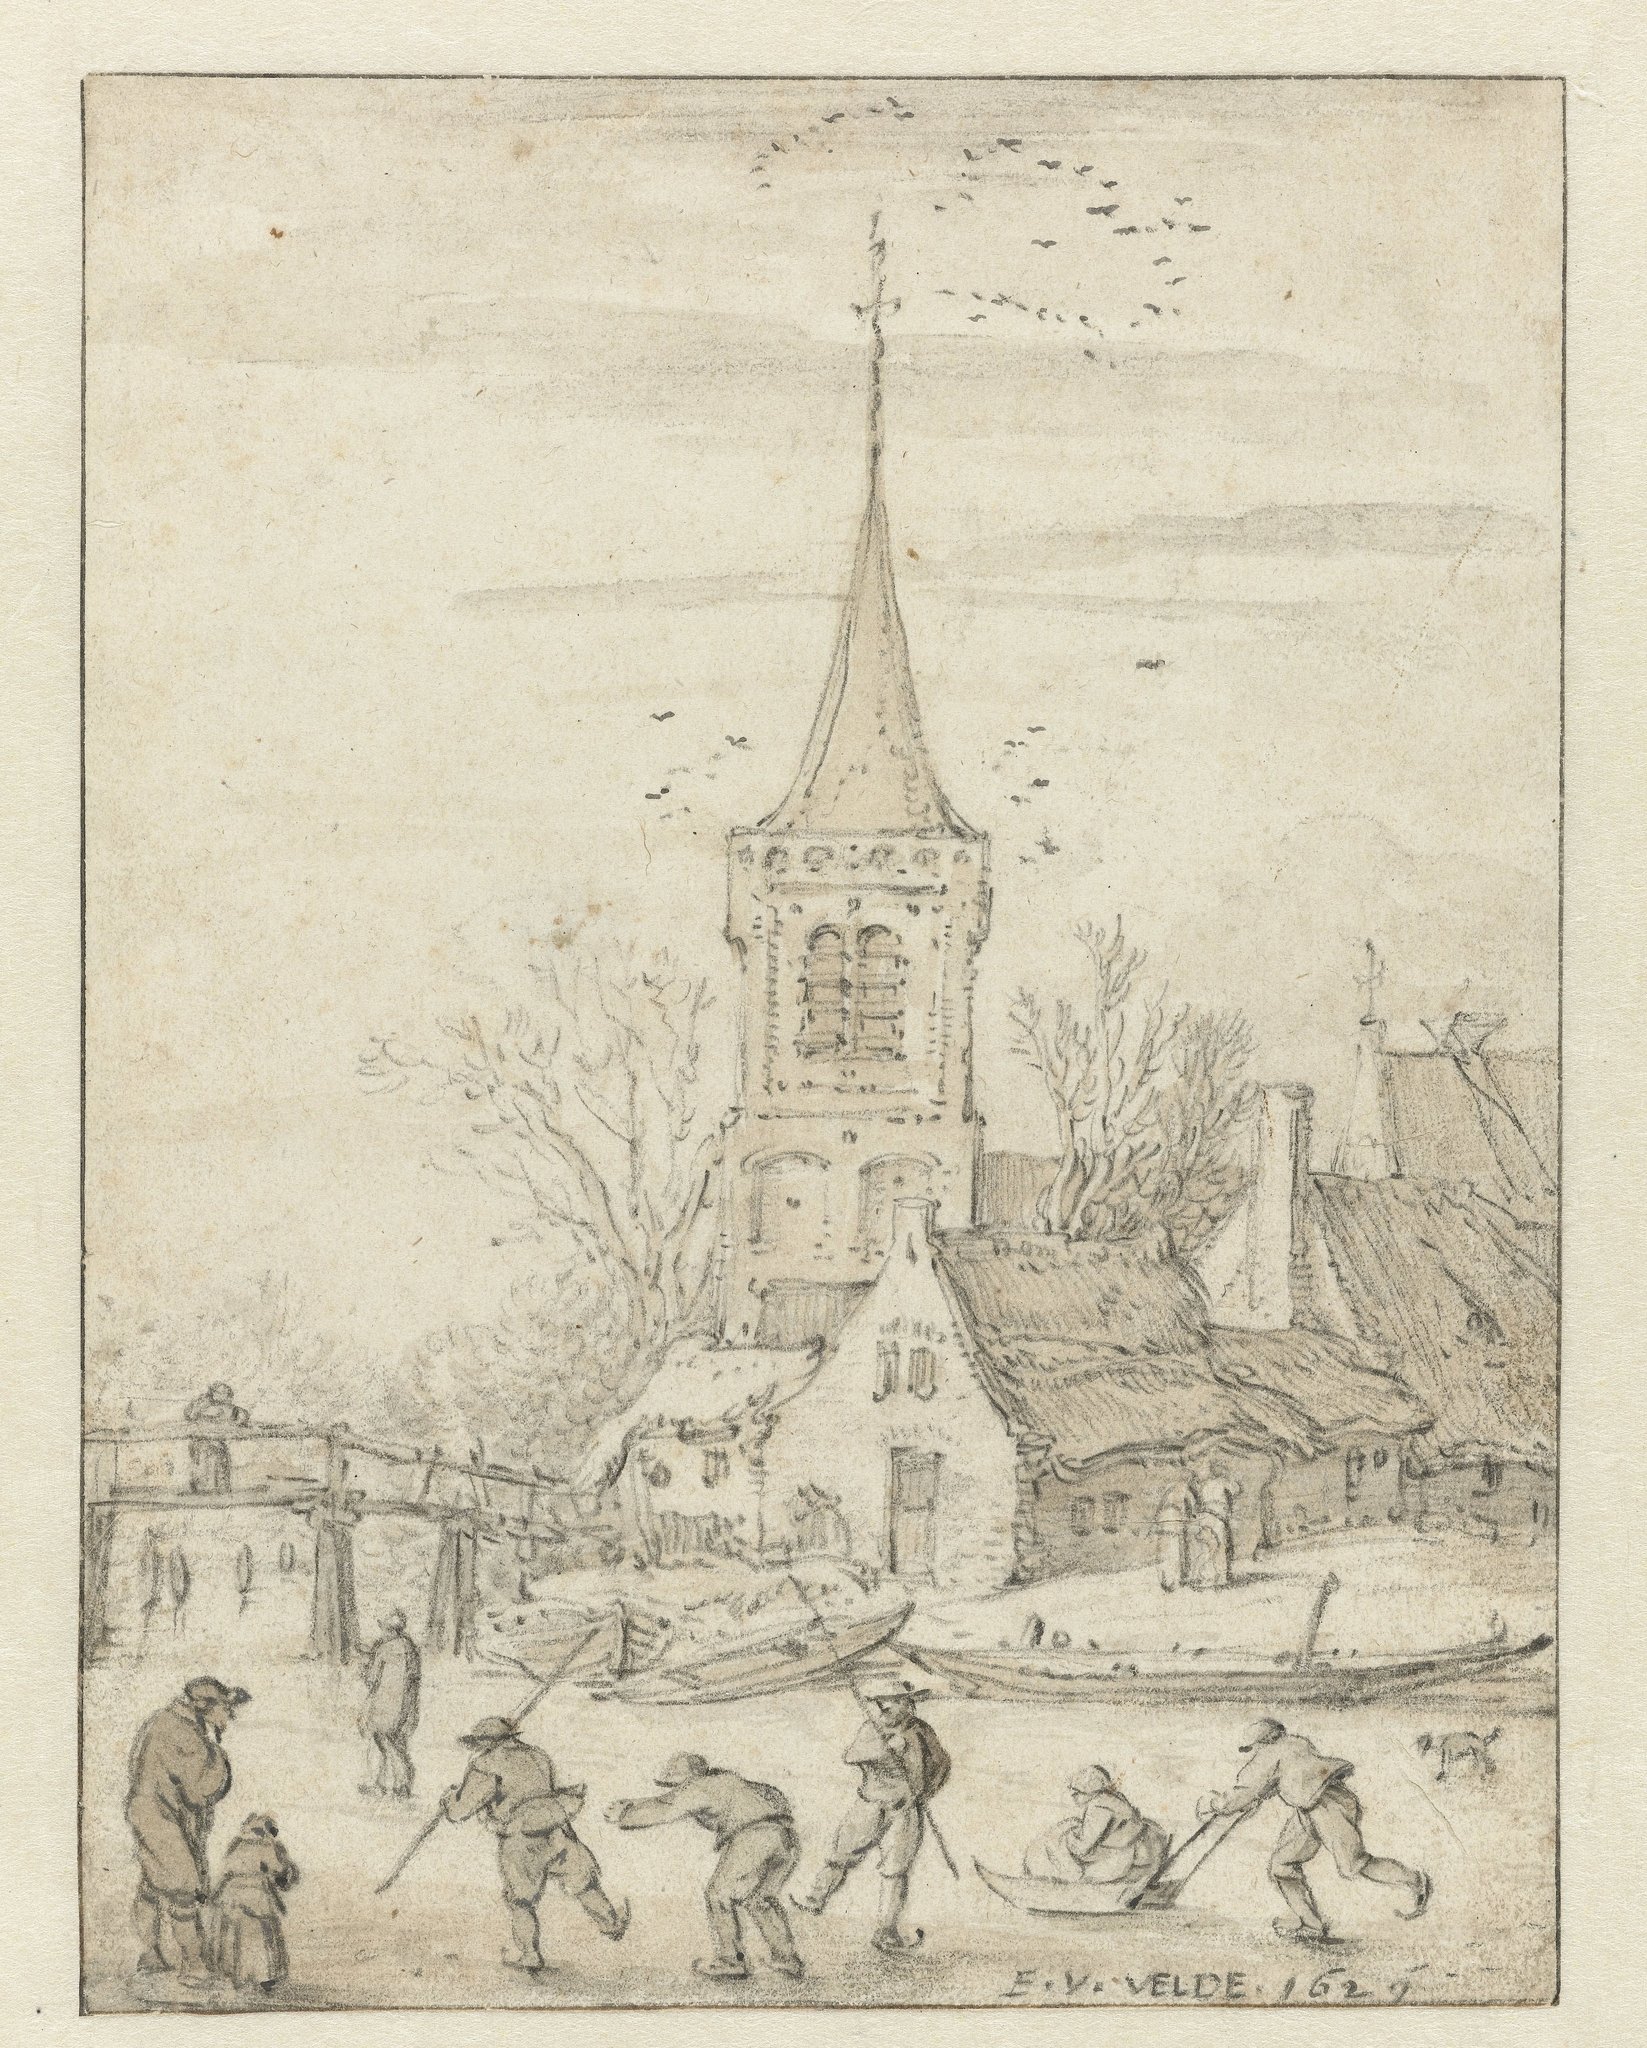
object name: drawing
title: Januari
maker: esaias van de velde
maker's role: draughtsman, painter, print maker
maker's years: 1587-1630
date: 1629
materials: chalk, paper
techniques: brush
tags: winter sports, january and its 'labours', church (exterior), ice ~ freezing weather, public road in village